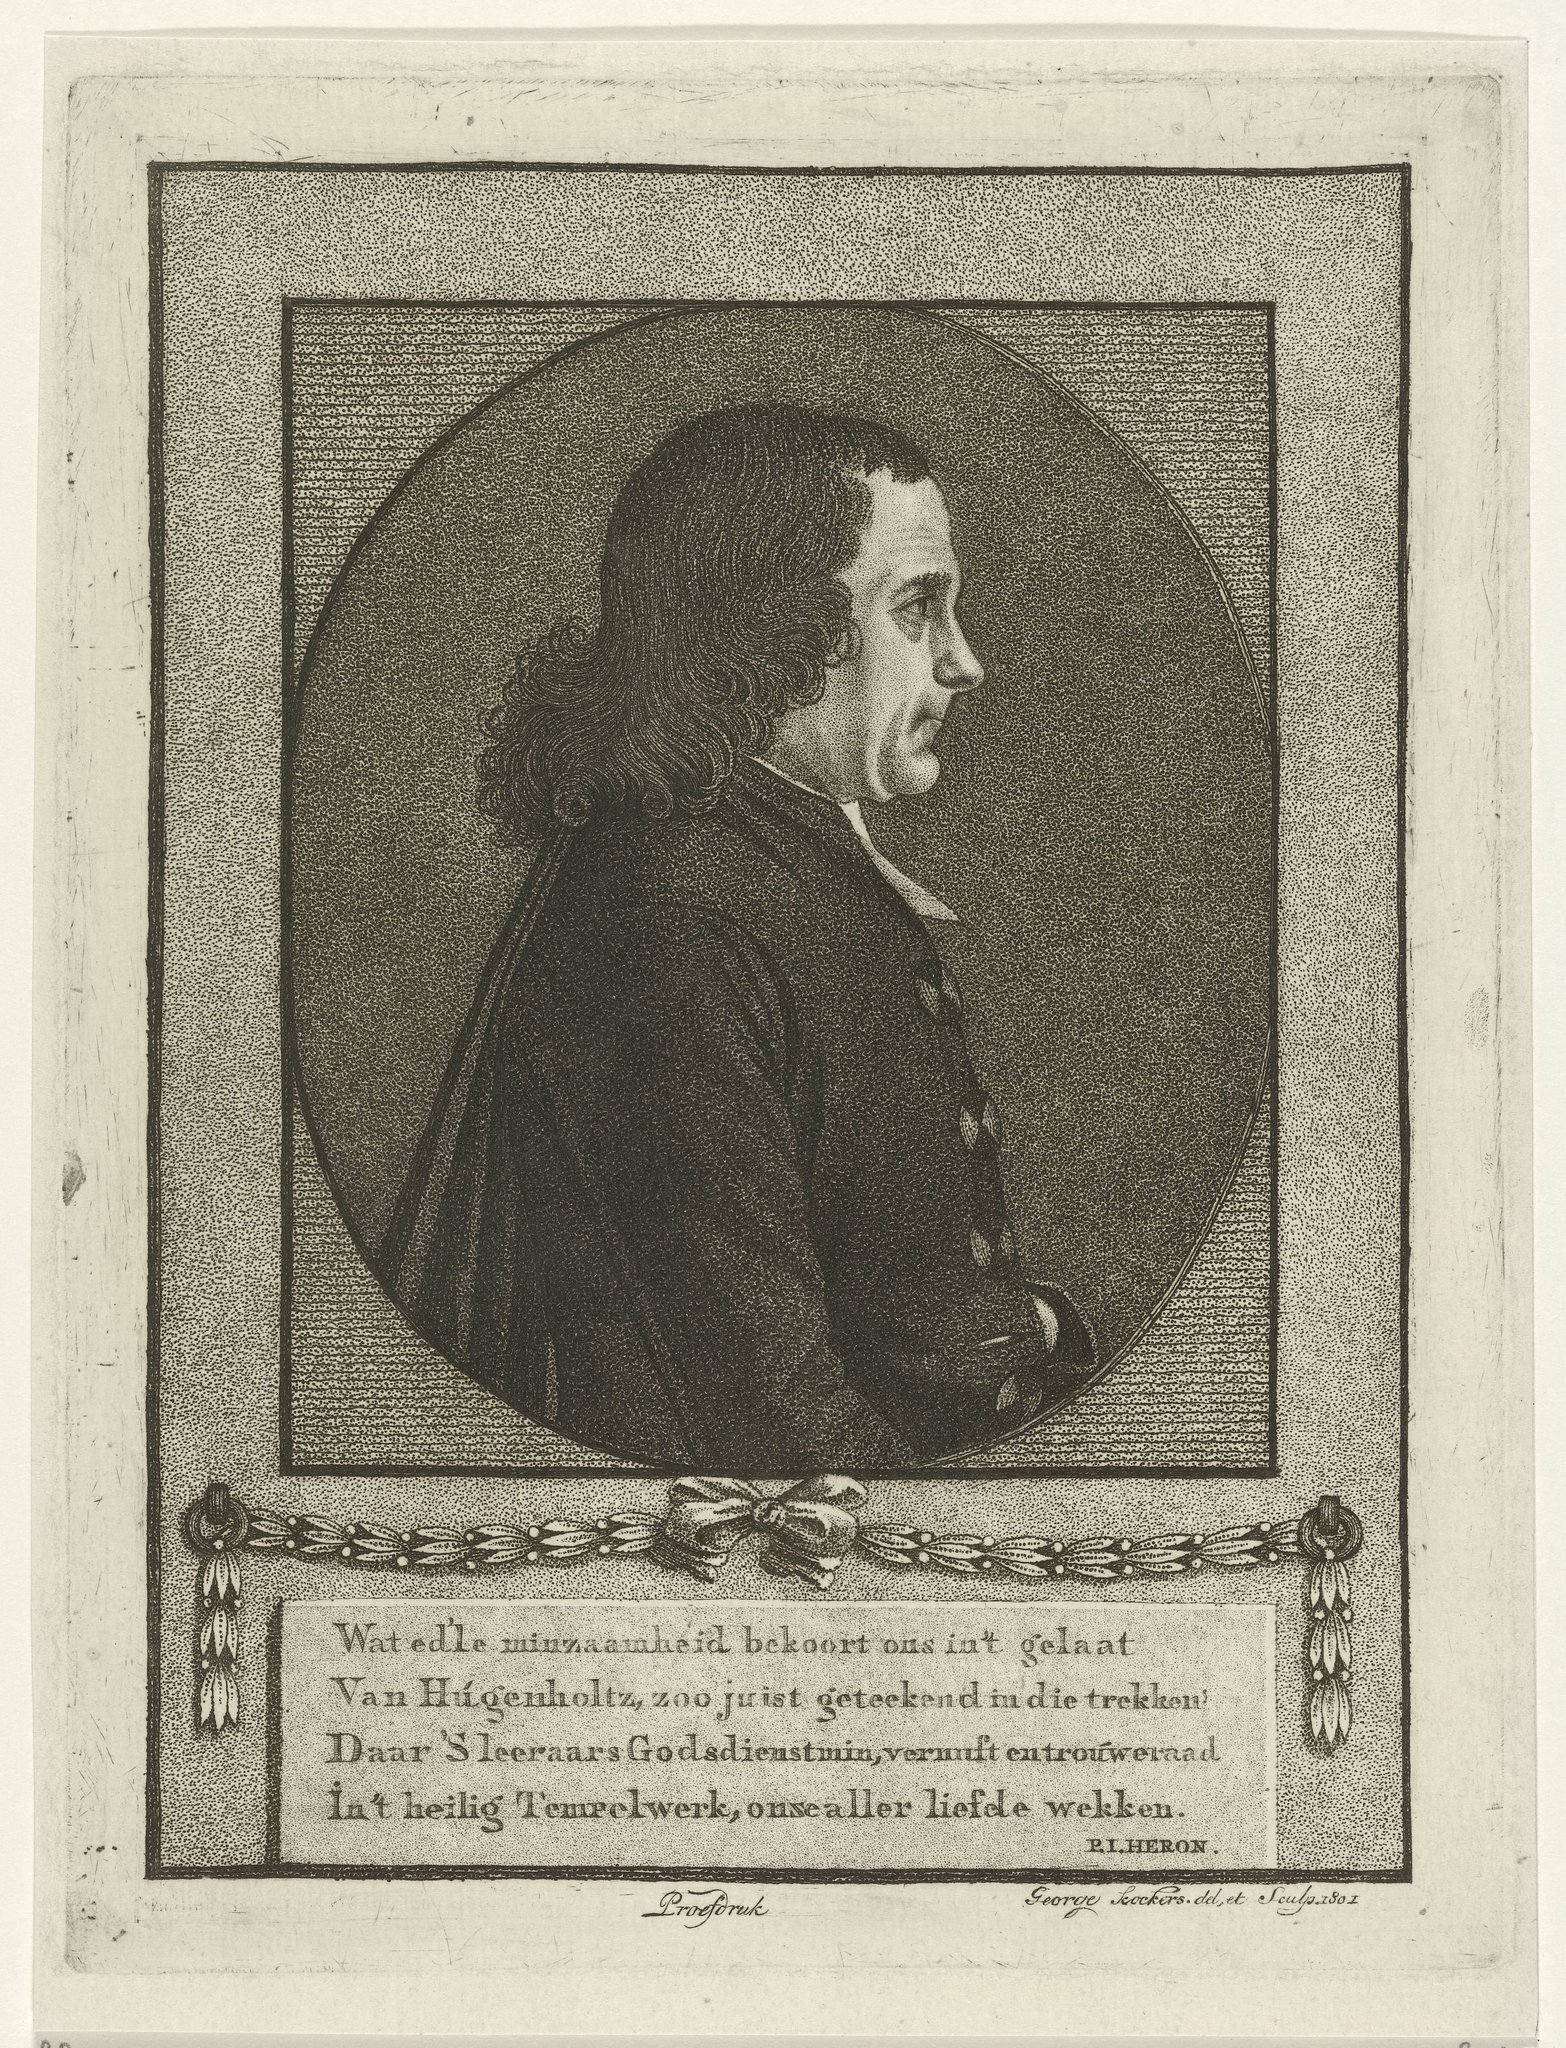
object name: print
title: Portret van Frederik Willem Hugenholtz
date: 1801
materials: paper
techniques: etching, engraving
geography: middelburg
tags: frederik willem hugenholtz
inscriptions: collector's mark: Lugt 2228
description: Portret ten halven lijve in profiel naar rechts van Frederik Willem Hugenholtz, predikant te Middelburg. Hugenholtz draagt een mantel en een bef en heeft zijn linkerhand in zijn bovenkleding gestoken. Onder het portret een vierregelig vers.